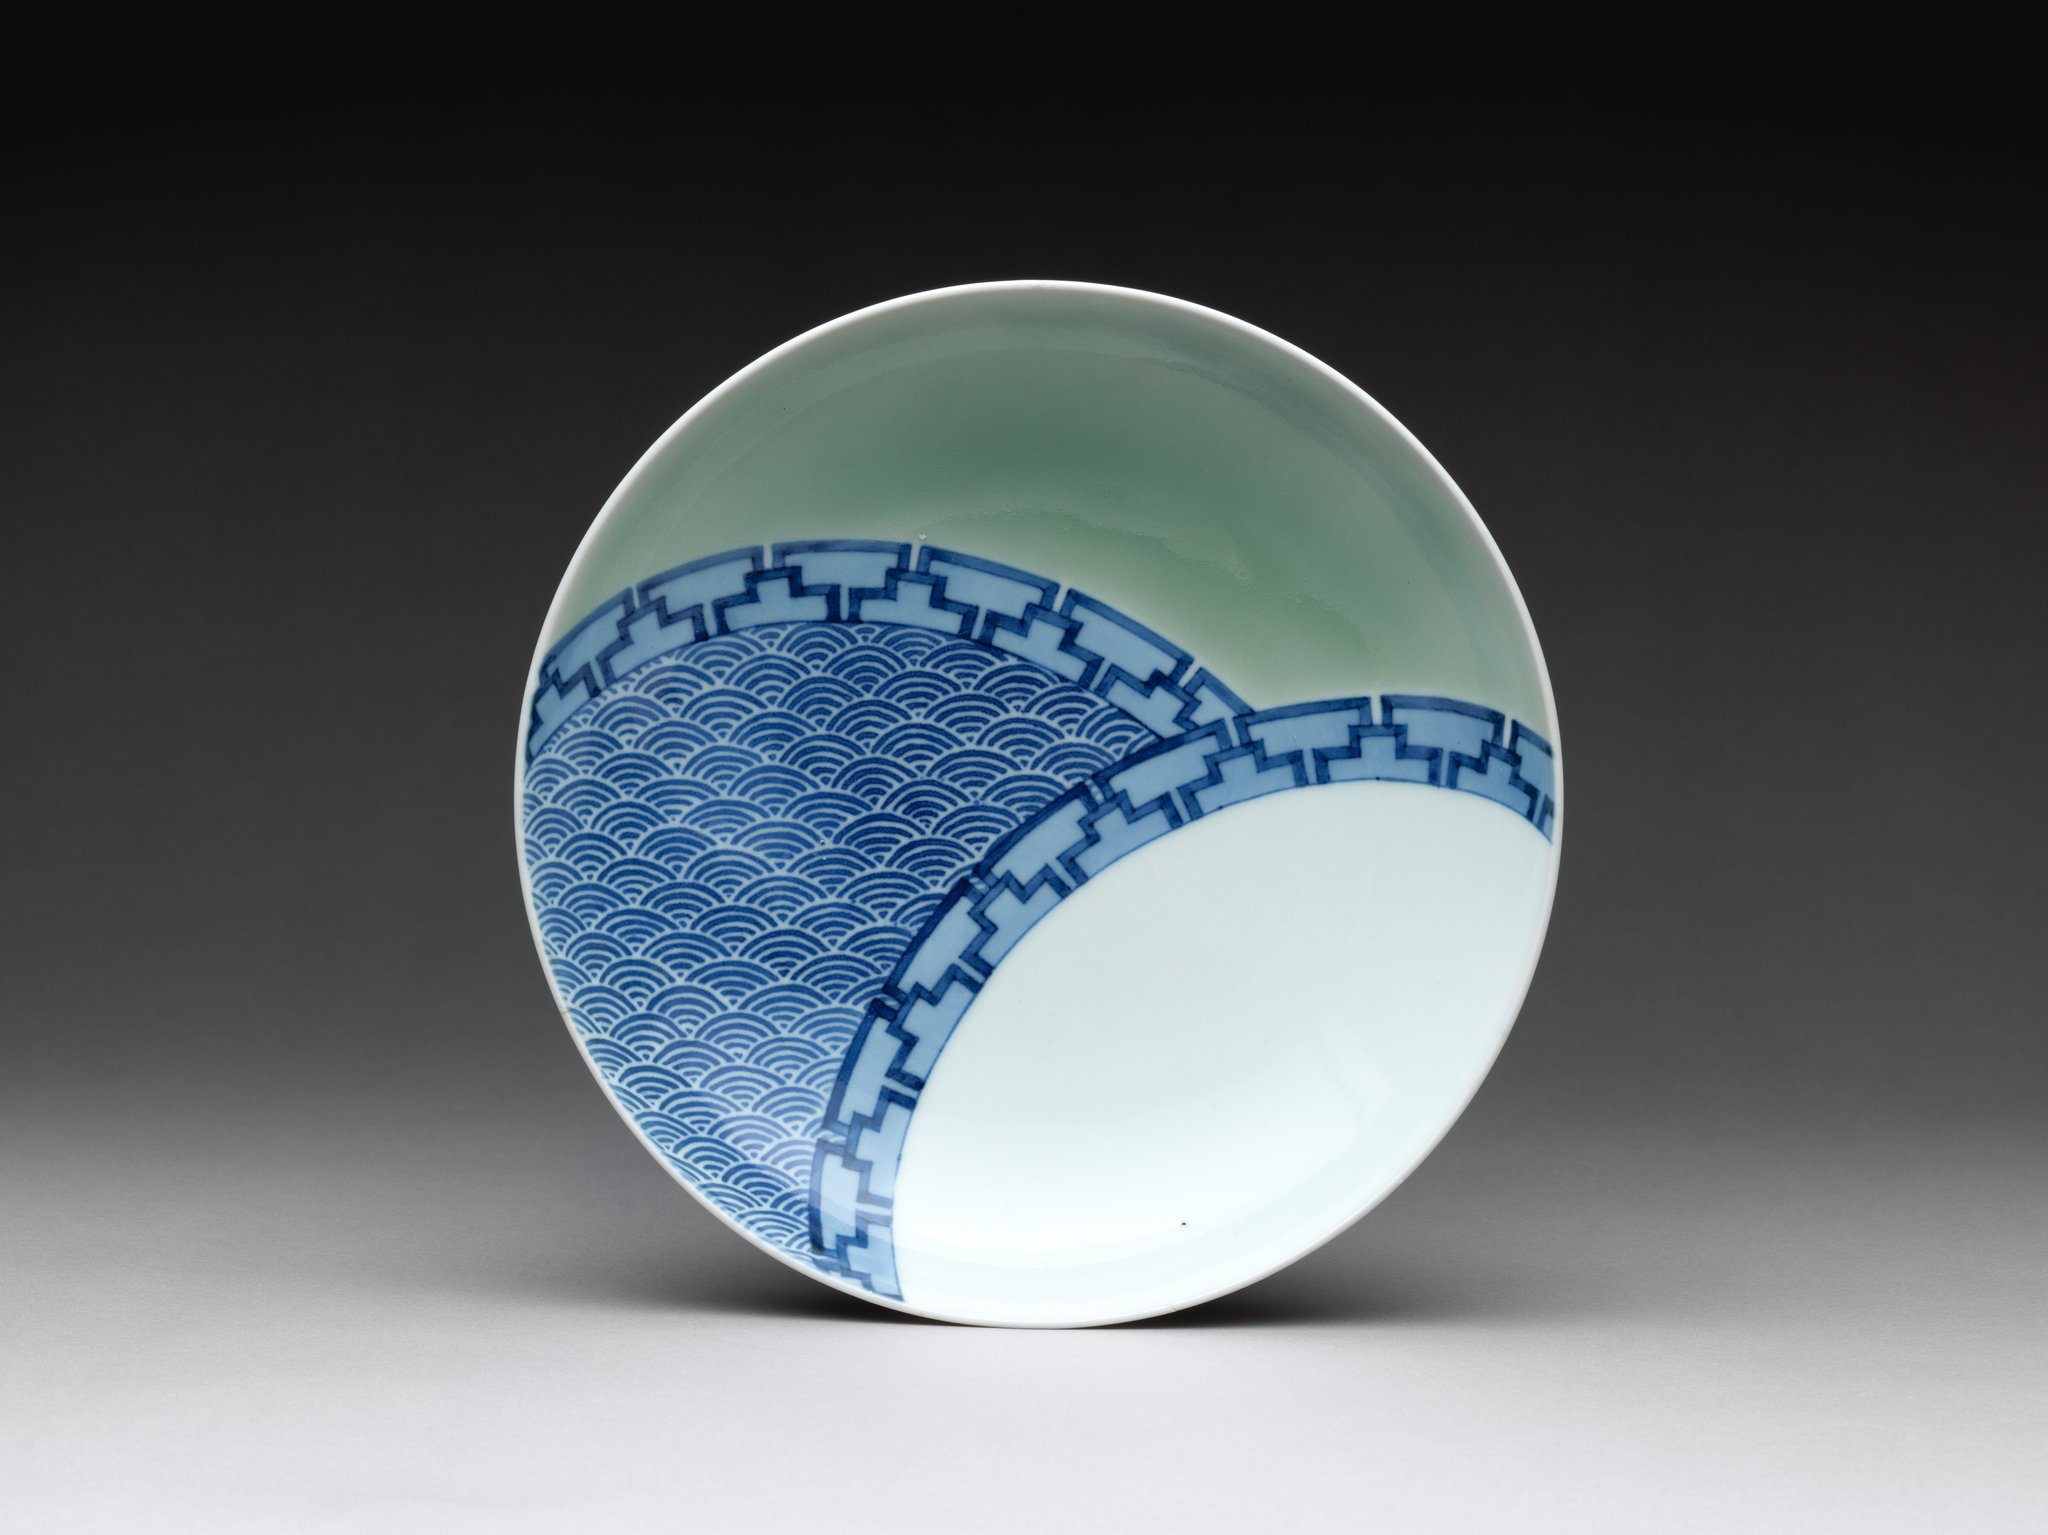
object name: dish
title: Dish with Design of Dishes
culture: japanese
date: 1690-1720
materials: ceramic glaze, glaze, porcelain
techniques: underglaze